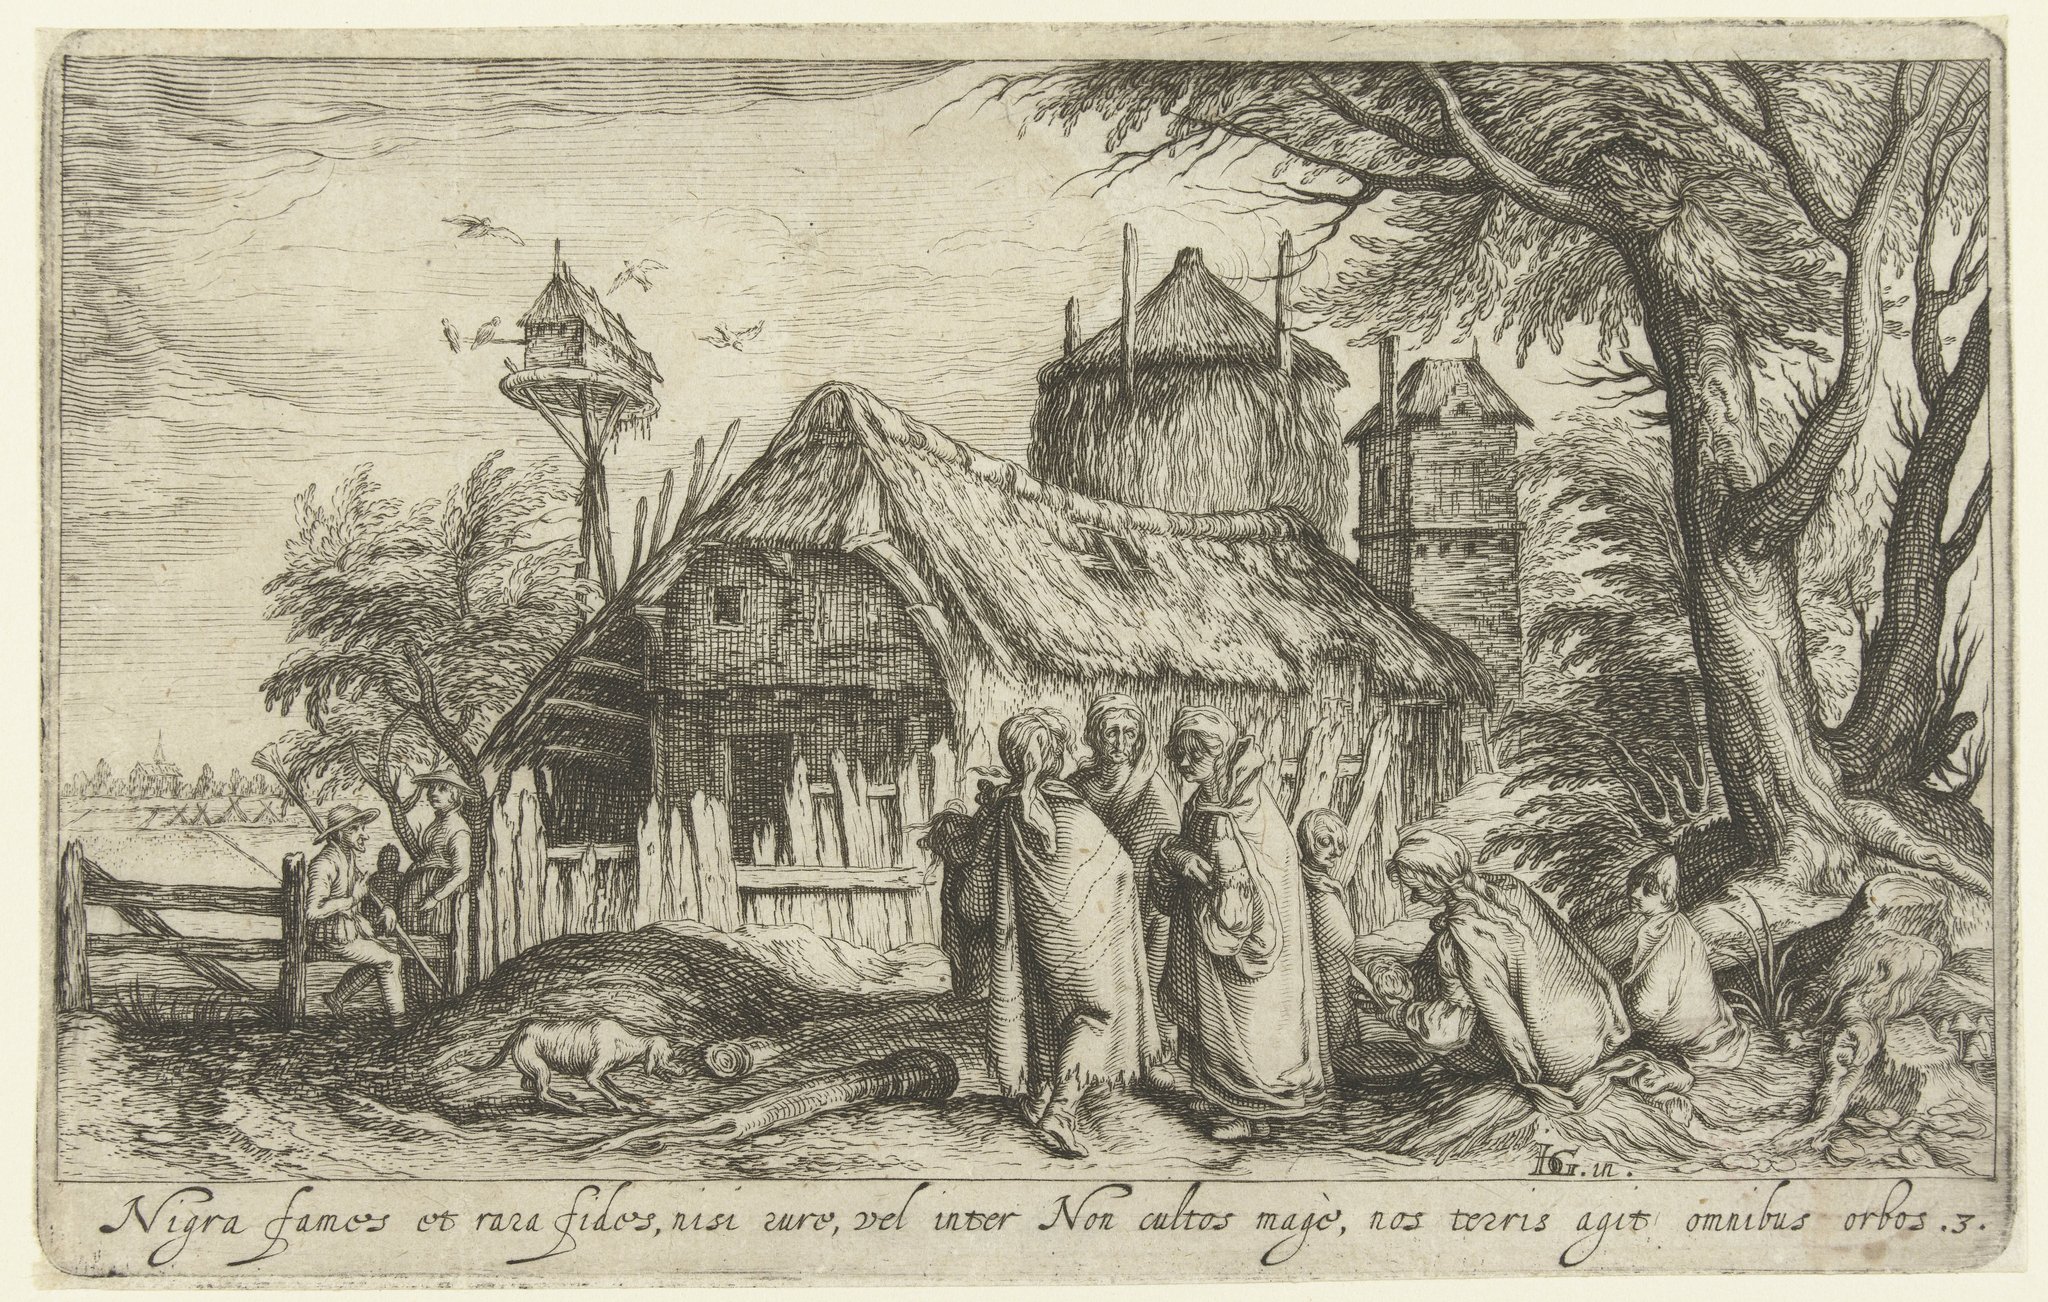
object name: print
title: Landschap met Roma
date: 1608-1612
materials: paper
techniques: engraving, etching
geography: delft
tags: landscapes, wandering communities: romani or roma, farm or solitary house in landscape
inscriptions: collector's mark: Lugt 240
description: Boerderij temidden van een aantal bomen, naast een weiland. Op de voorgrond een groep van zes zigeuners. Links op de achtergrond een kerk. Onder de voorstelling één regel Latijnse tekst. Deze prent is onderdeel van een serie van zes (op één na) genummerde prenten met landschappen.